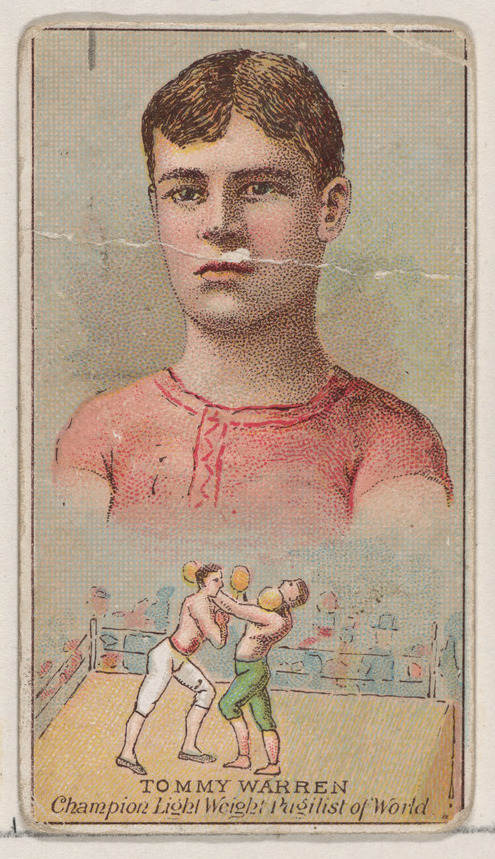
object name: print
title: Tommy Warren, Champion Light Weight Pugilist of the World, from the Champions of Games and Sports series (N184, Type 2) issued by W.S. Kimball & Co.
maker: w.s. kimball & co.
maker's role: publisher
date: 1887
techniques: color lithograph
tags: men,boxing,athletes